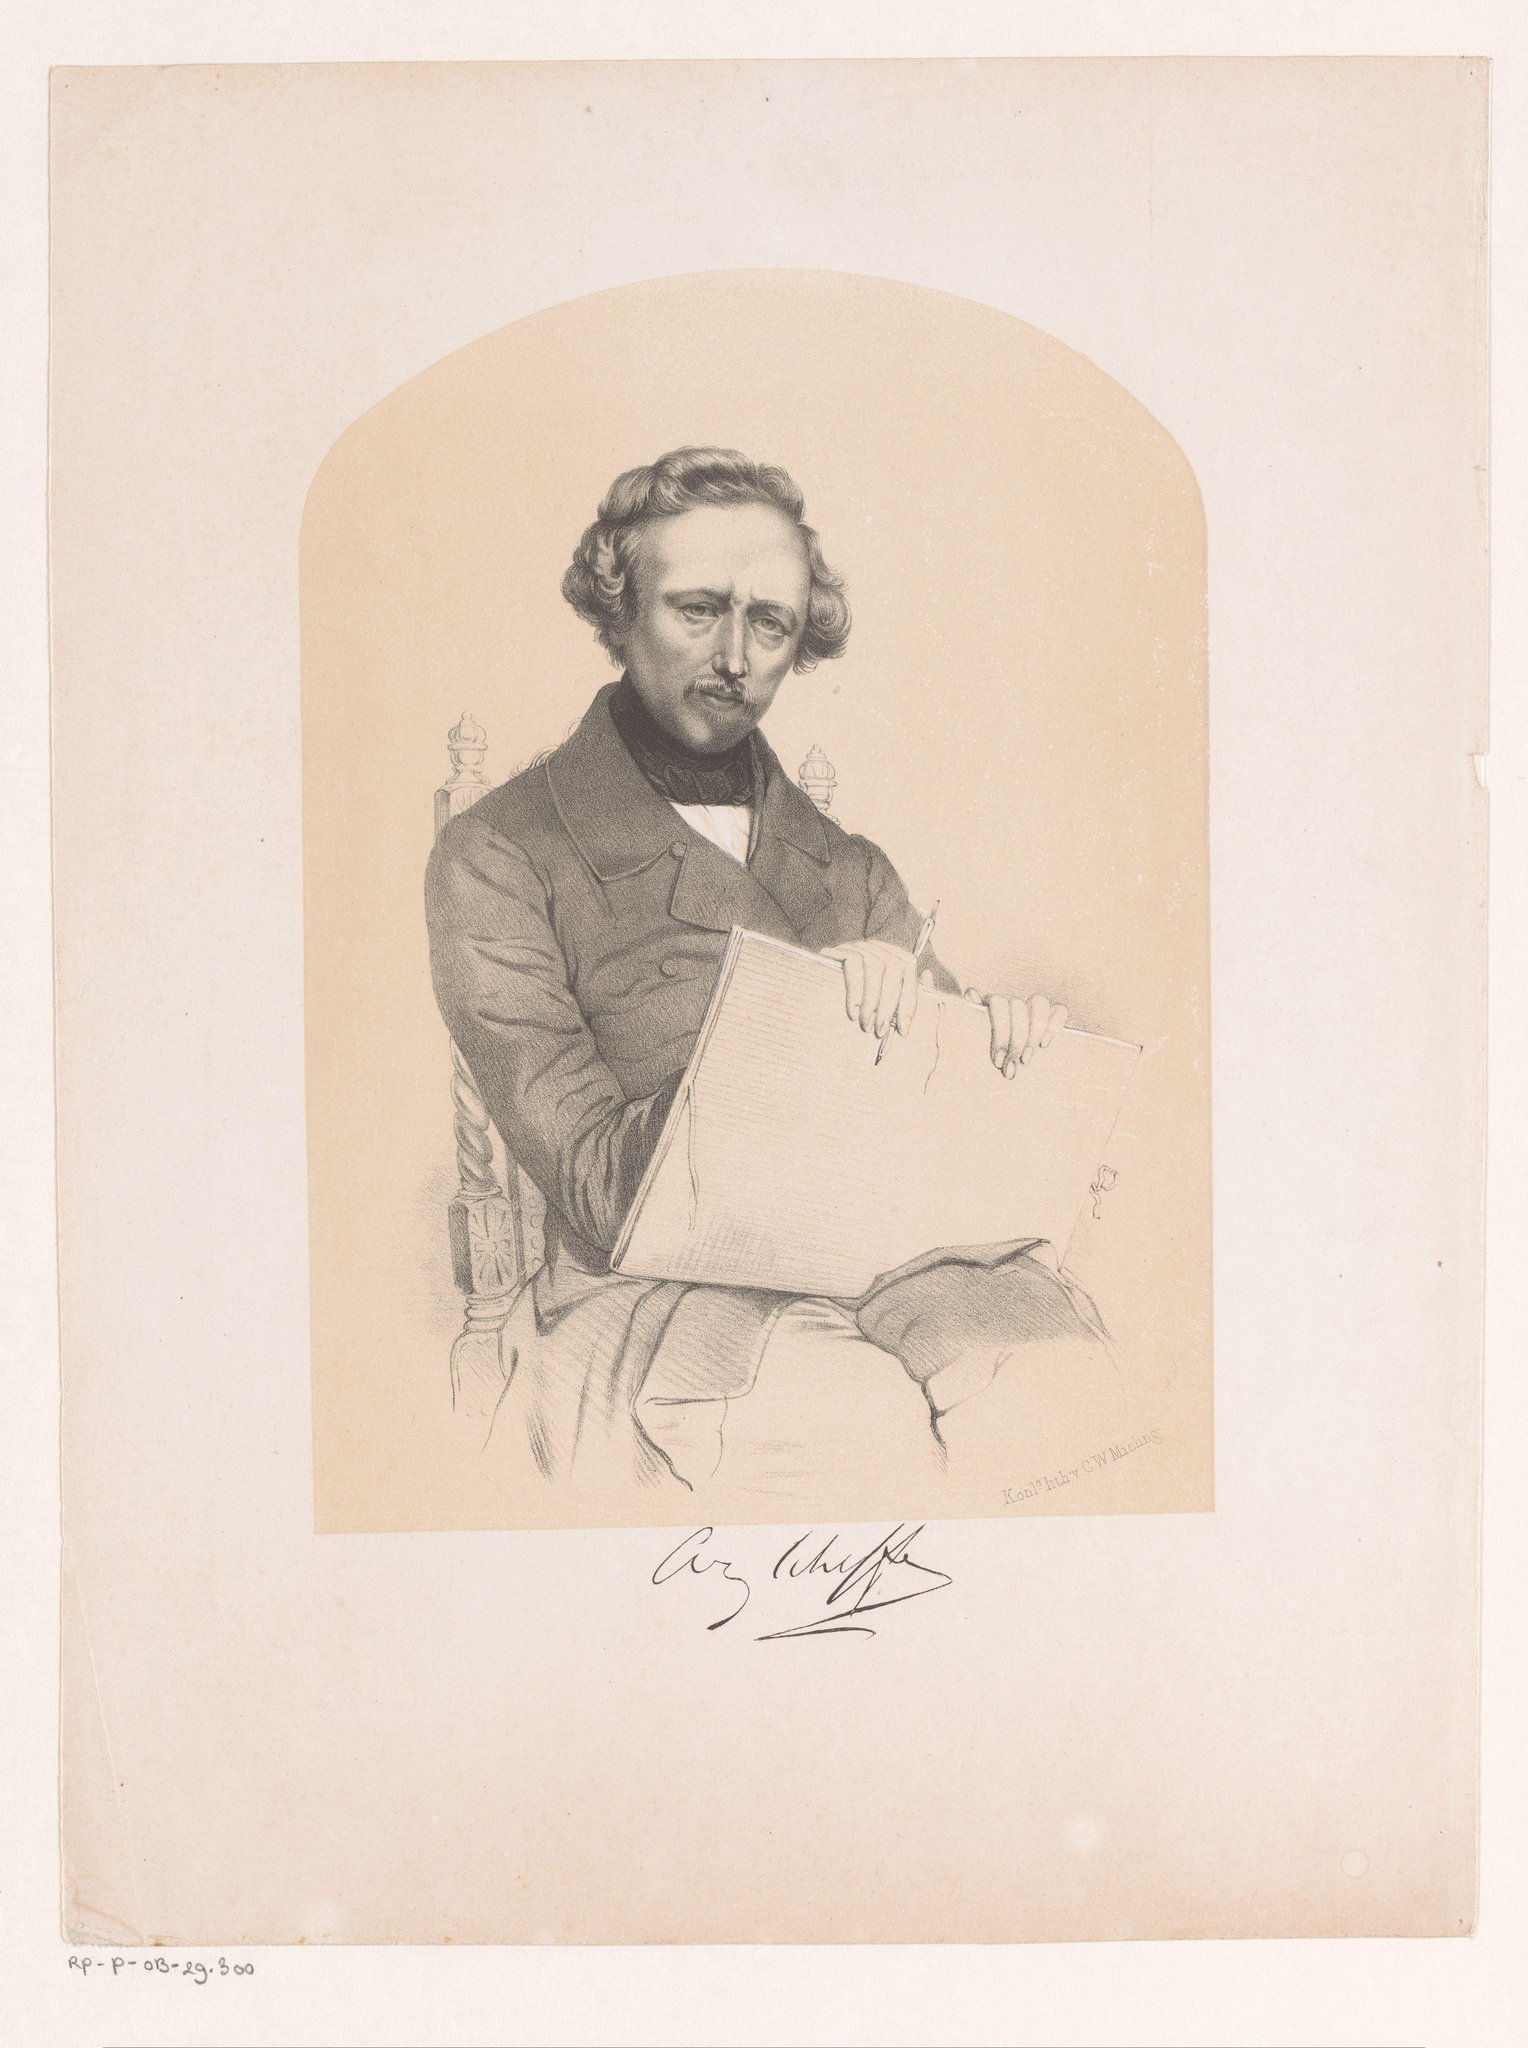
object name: print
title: Portret van Ary Scheffer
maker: Anonymous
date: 1847-1865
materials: paper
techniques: tone lithography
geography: the hague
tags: painter, ary scheffer, drawing, sketch, historical persons (+ half-length portrait), portrait, self-portrait of artist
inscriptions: collector's mark: Lugt 2228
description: De kunstenaar zit op een stoel met een map tekeningen op schoot. Onder het portret zijn signatuur.